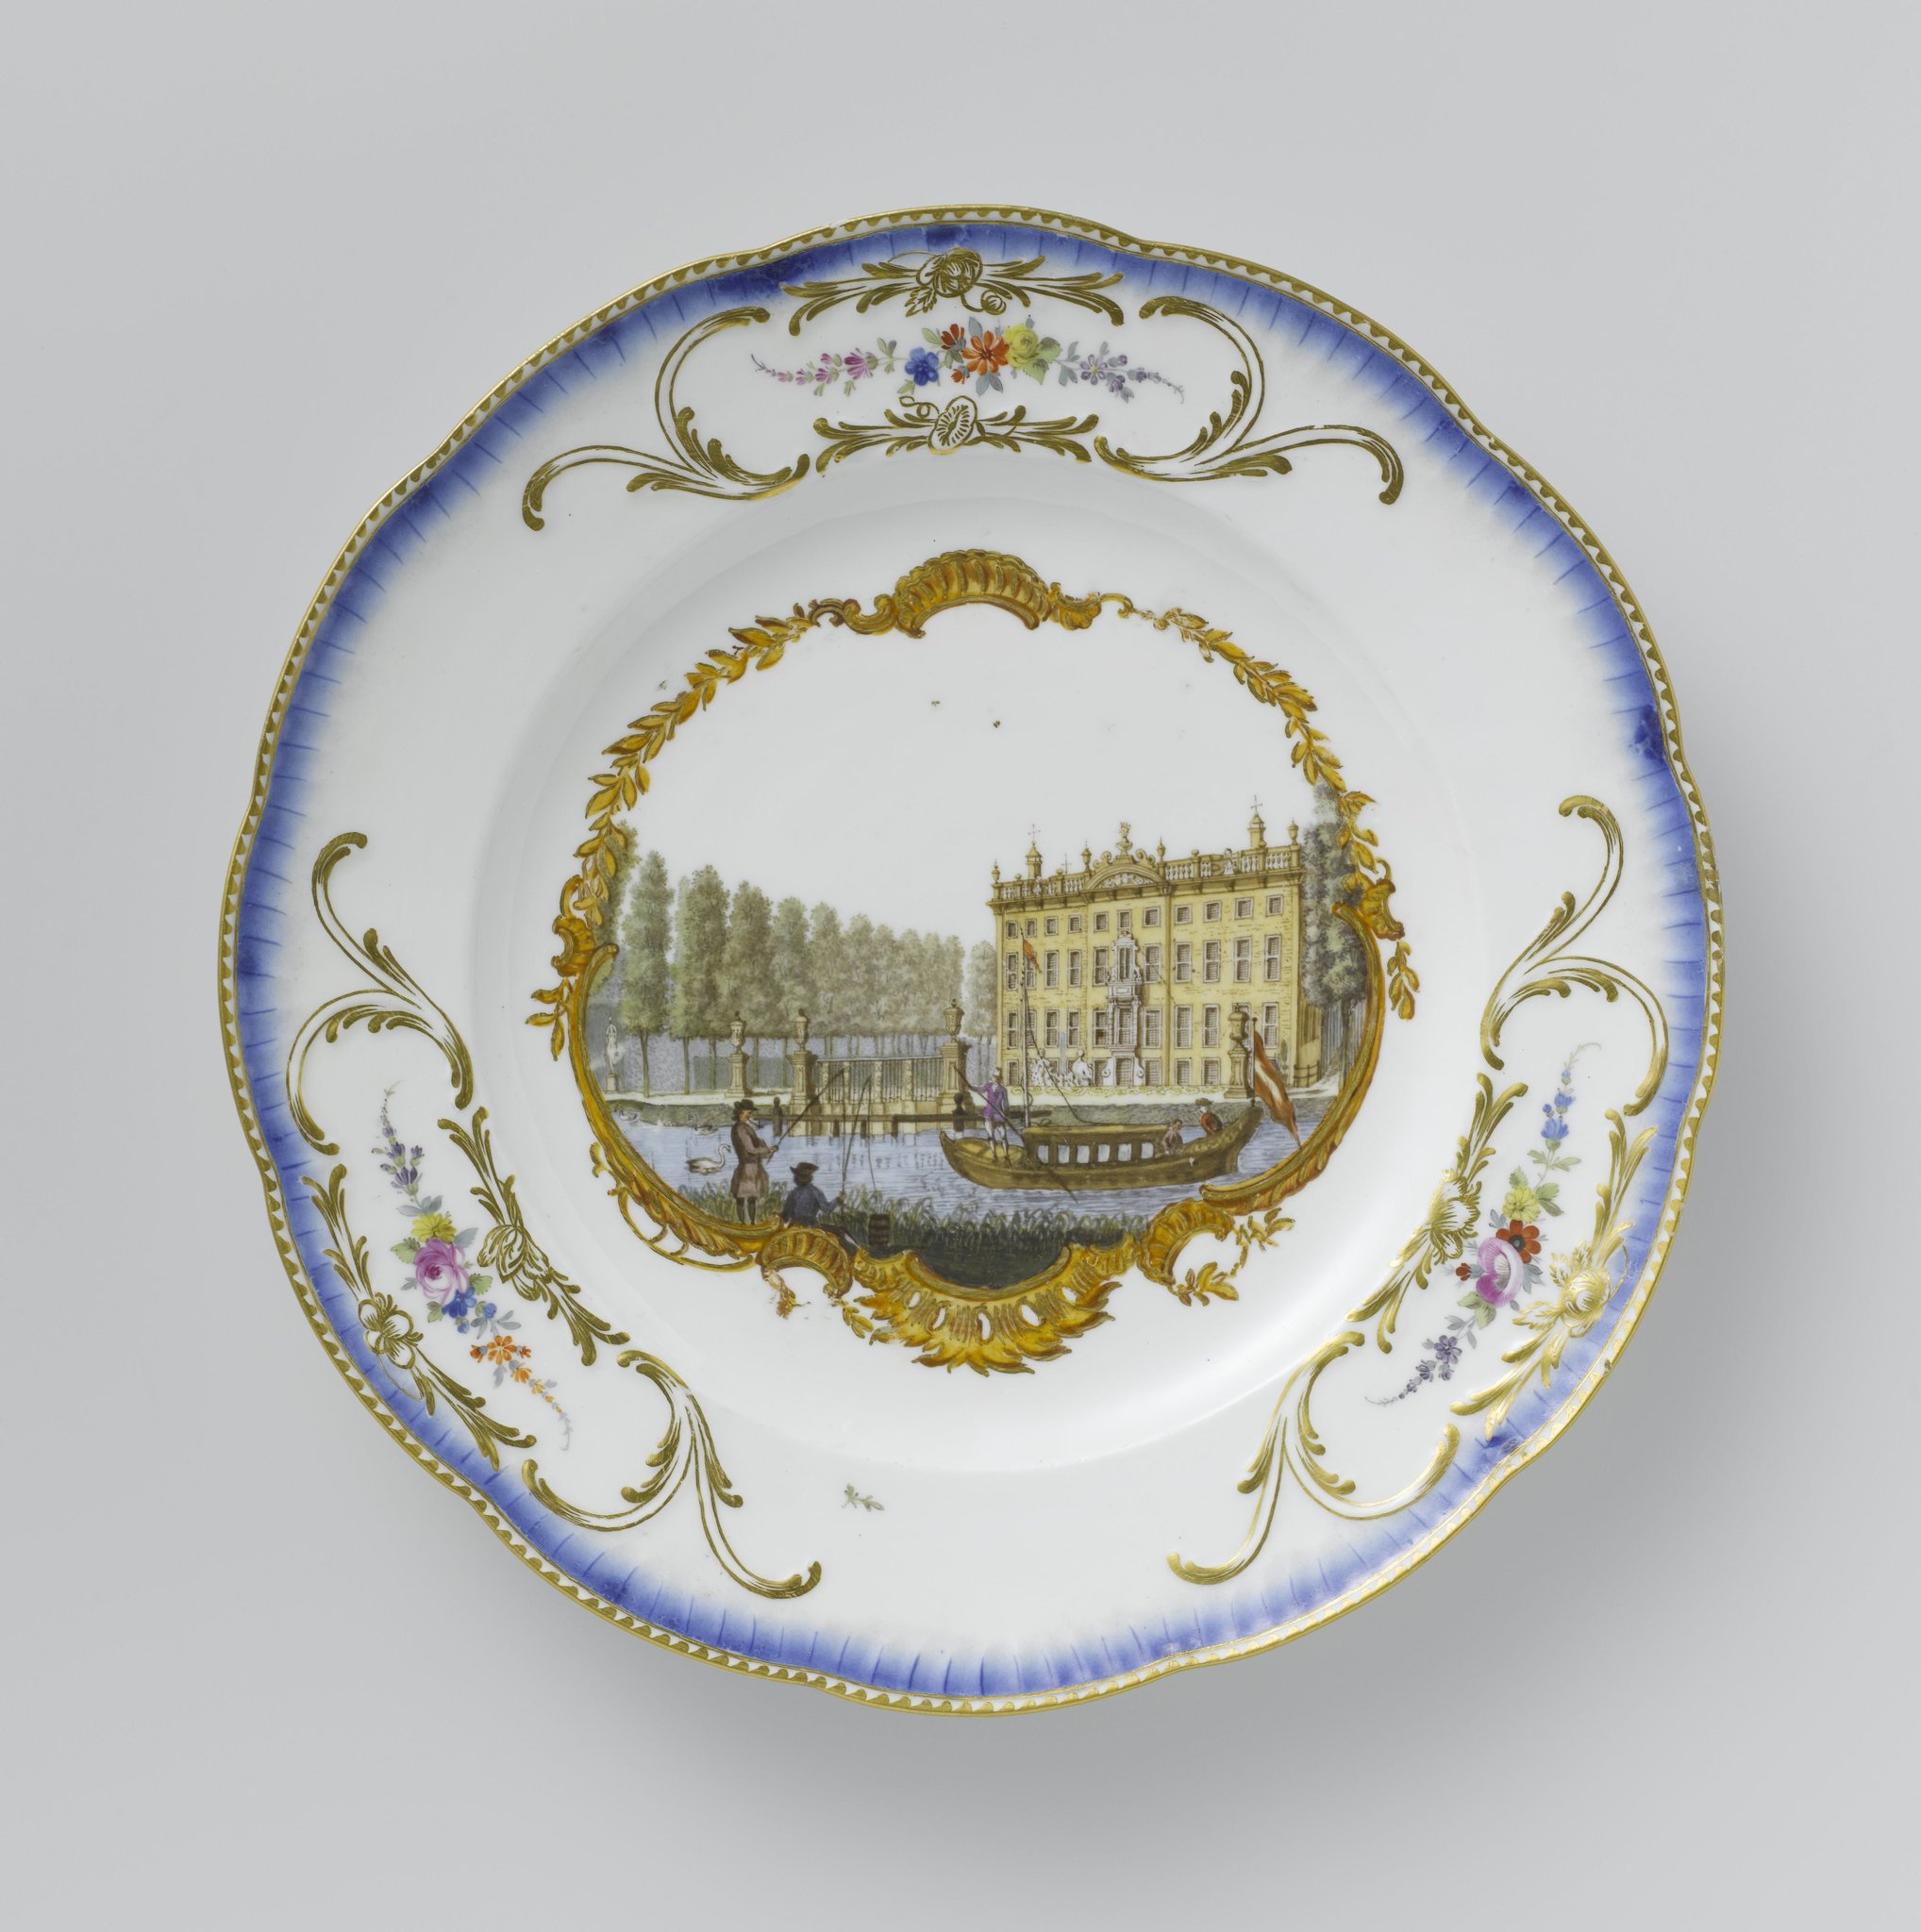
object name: eating drinking utensil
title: Seven plates from the service of Stadtholder William v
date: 1772-1774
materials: porcelain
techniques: painted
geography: meissen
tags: the hague, william v (prince of orange)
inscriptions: mark, mold mark: ‘39’, inscription: ‘Het Huijs Termeer bij Maarsen van de Vegt te zien’, painter's mark: ‘J’, factory mark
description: These seven plates are from a 435-part service owned by Stadtholder William v of Orange. The service was produced in Meissen between 1772 and 1774, possibly on commission for the Dutch East India Company (VOC). The plates bear scenes of various Dutch cities and buildings, as well as views of Java and Ceylon, then important Company territories.